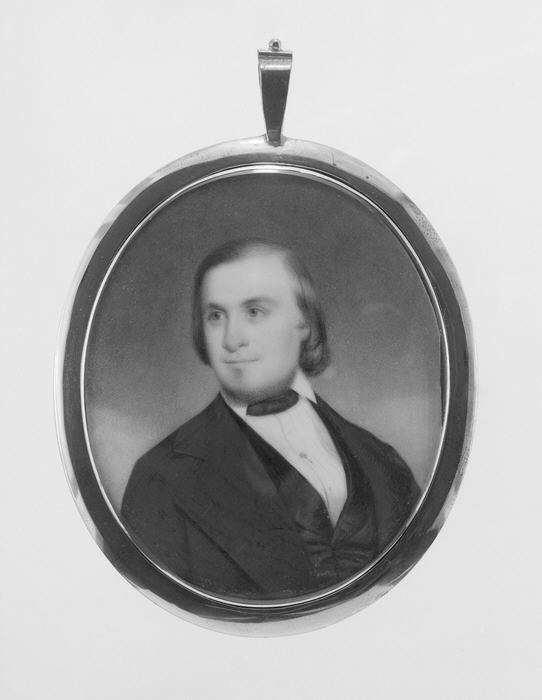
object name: painting, miniature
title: Portrait of a Gentleman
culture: american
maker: edward s. dodge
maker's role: artist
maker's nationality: american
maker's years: 1816-1857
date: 1840-1845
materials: ivory, watercolor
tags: men,portraits